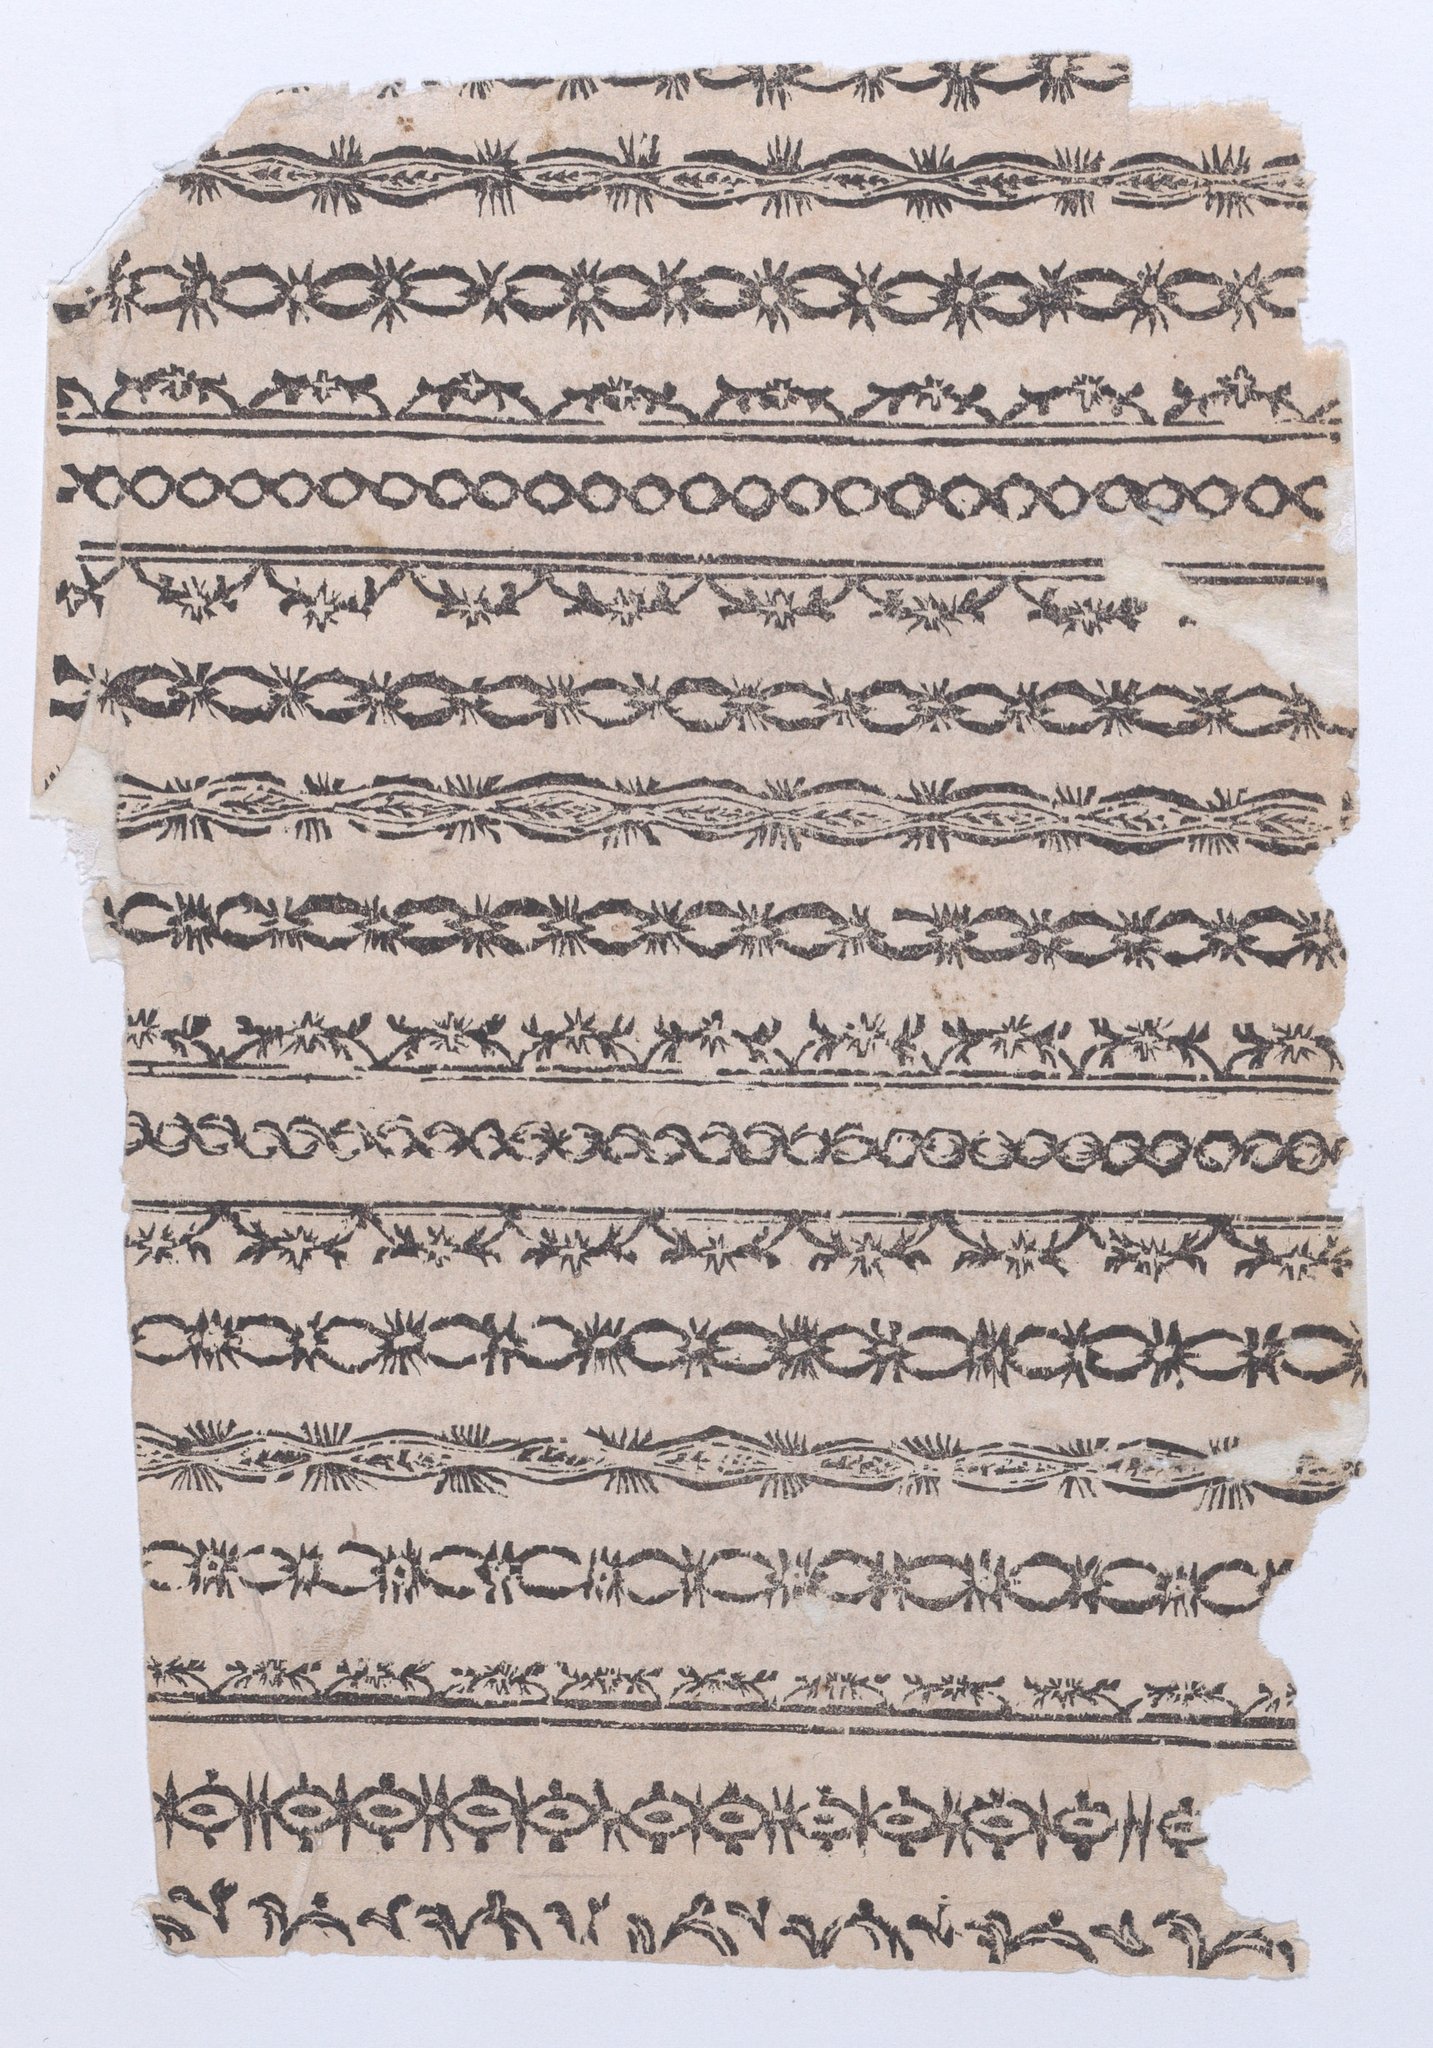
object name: print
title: Sheet with various vertical designs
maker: Anonymous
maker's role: artist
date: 1801-1900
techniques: relief print